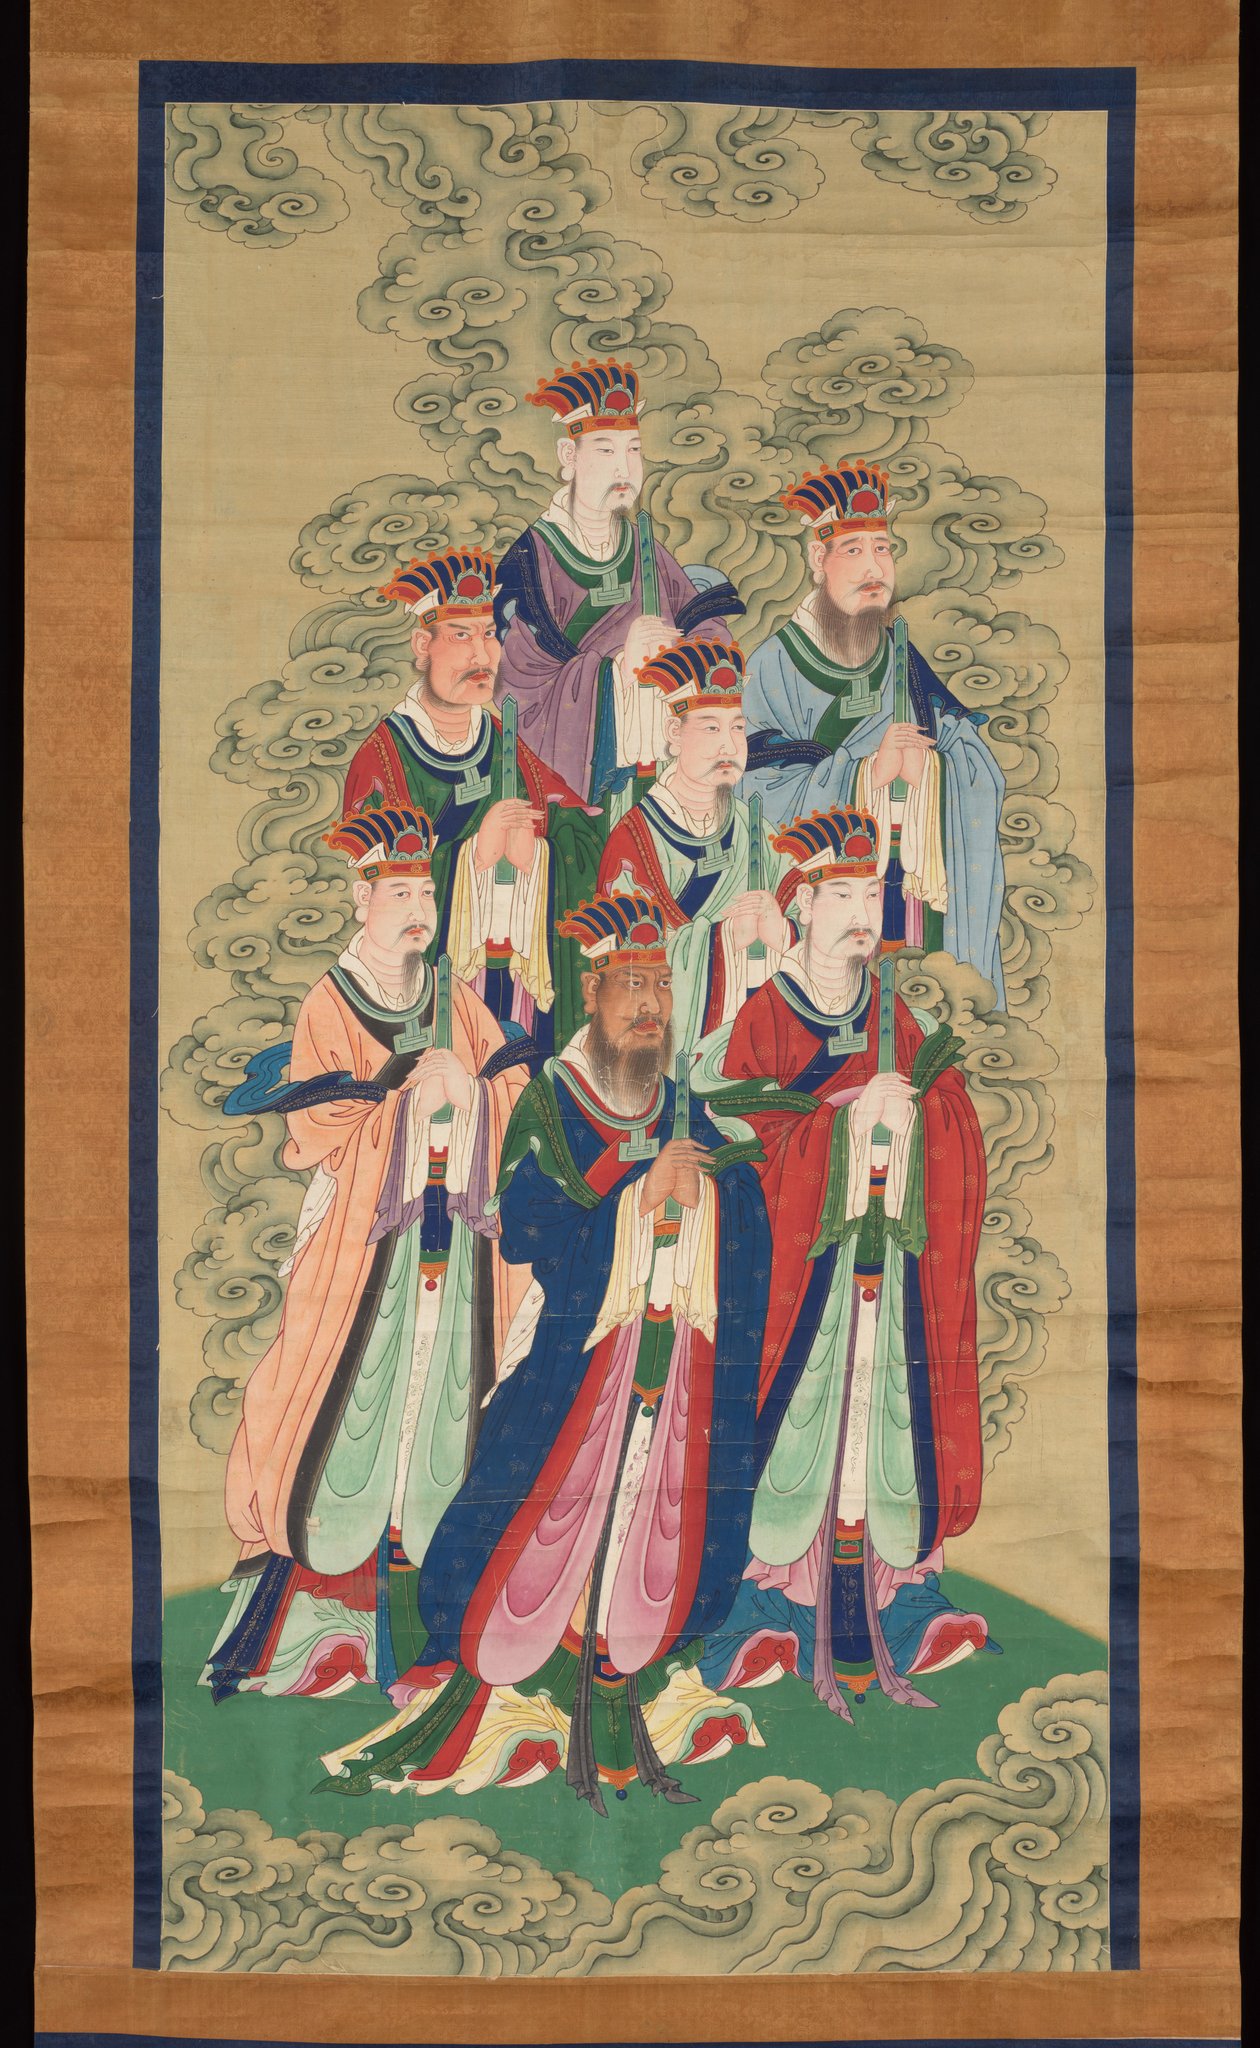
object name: hanging scroll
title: Seven Dignitaries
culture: chinese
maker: unidentified artist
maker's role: artist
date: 1368-1911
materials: silk